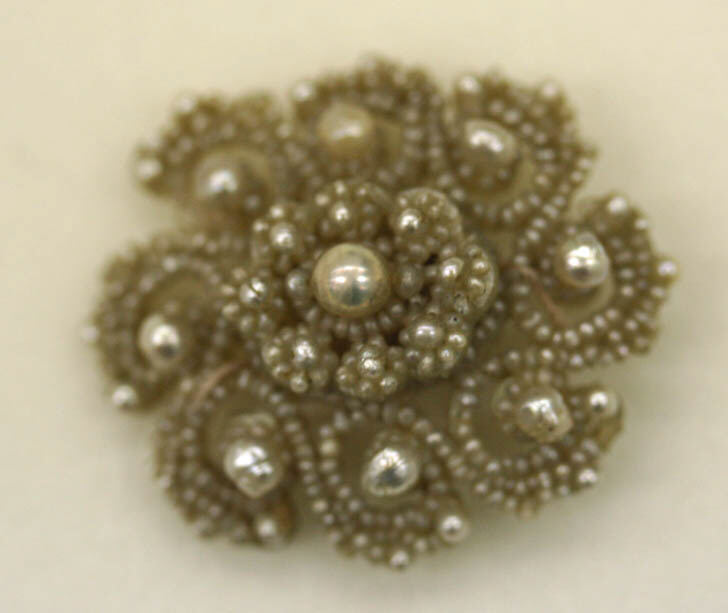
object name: brooch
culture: american or european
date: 1801-1900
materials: gold, pearl